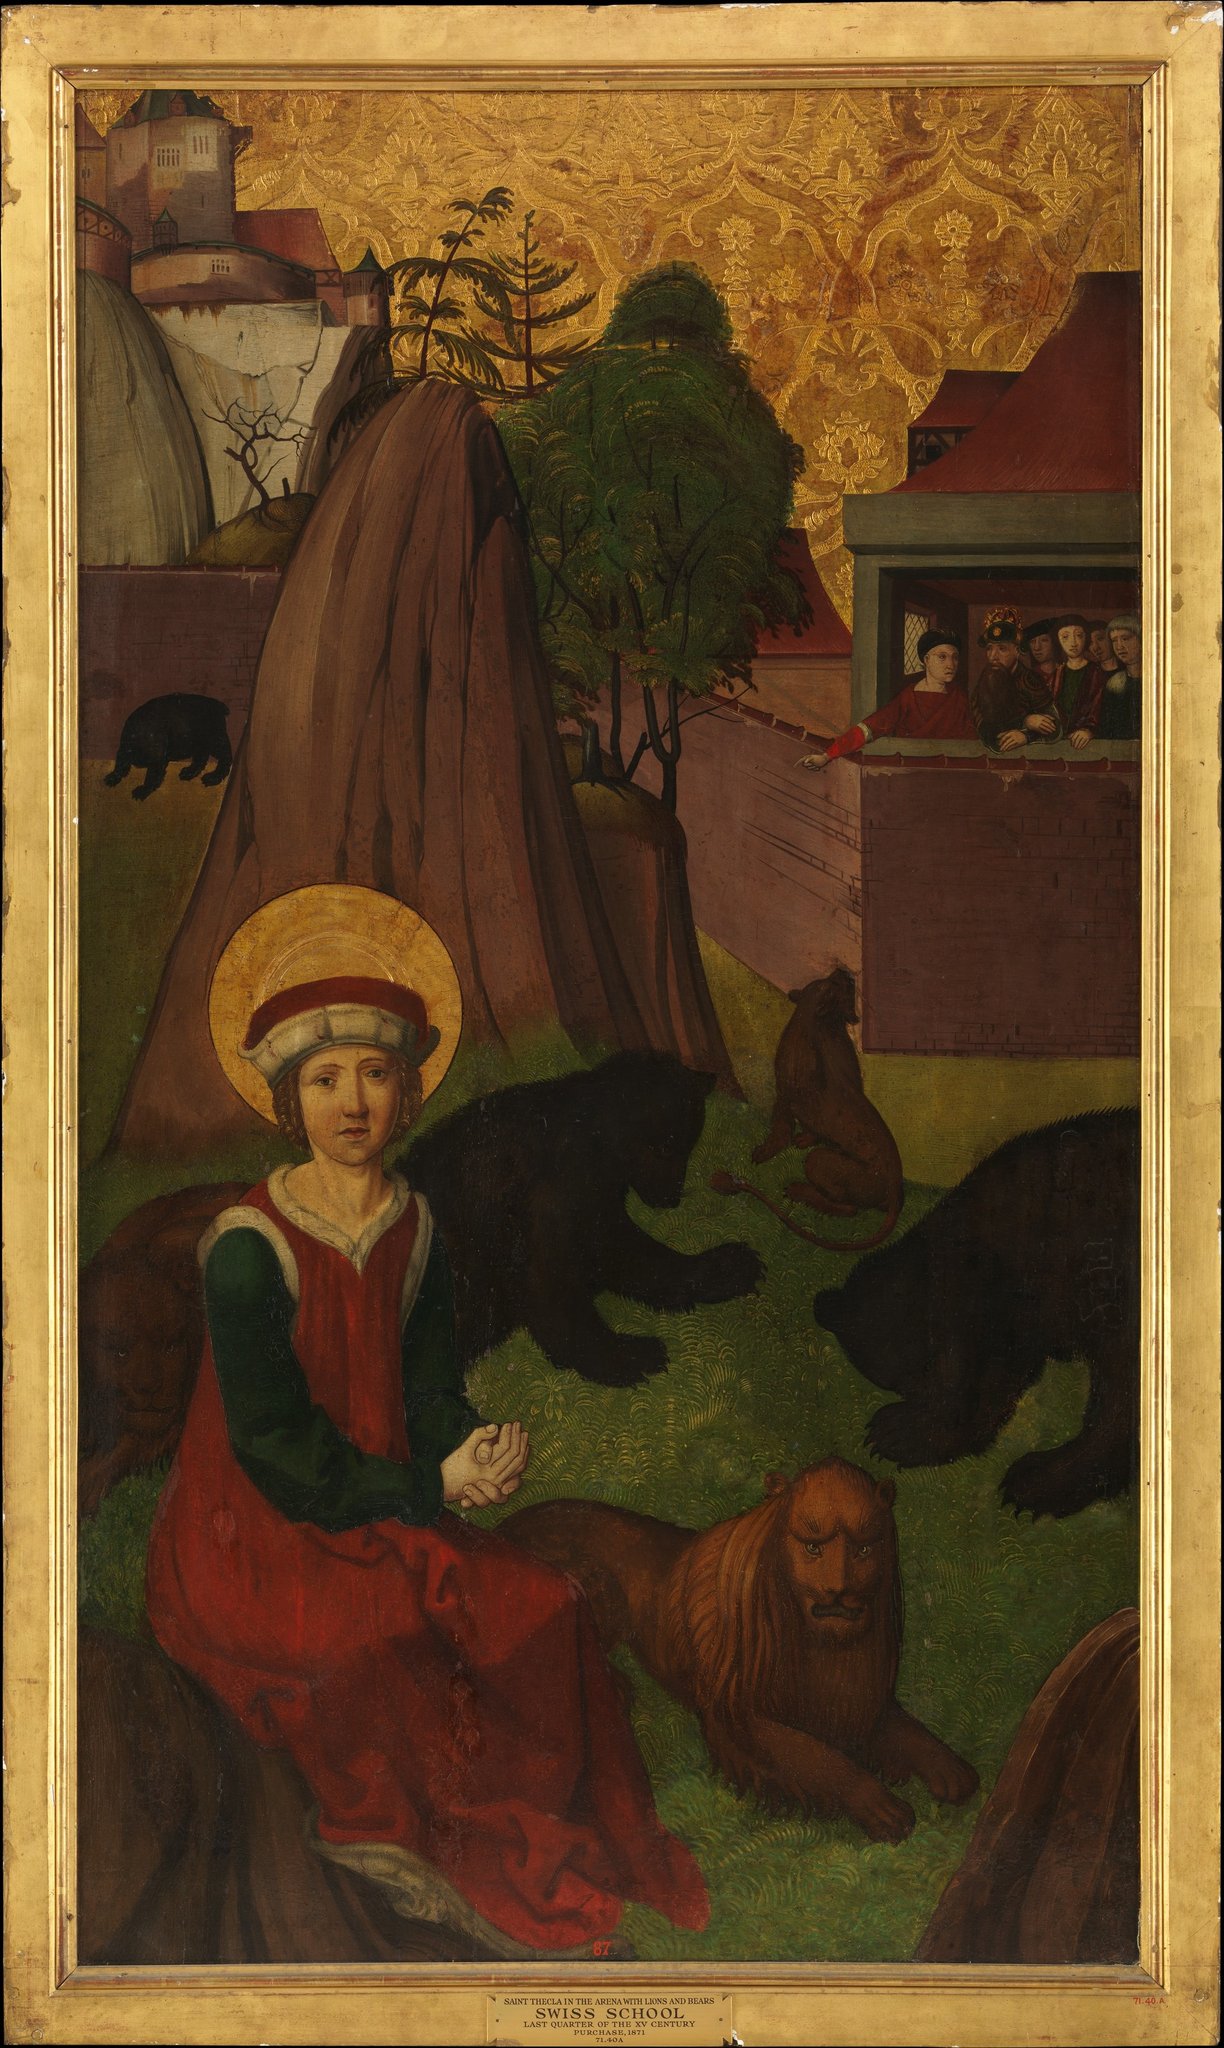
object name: painting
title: Saint Agapitus of Praeneste in the Arena; (interior) The Beheading of Saint Agapitus of Praeneste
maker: swiss painter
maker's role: artist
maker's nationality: swiss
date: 1500-1505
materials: gold, metal, oil, wood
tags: bears,lions,saints